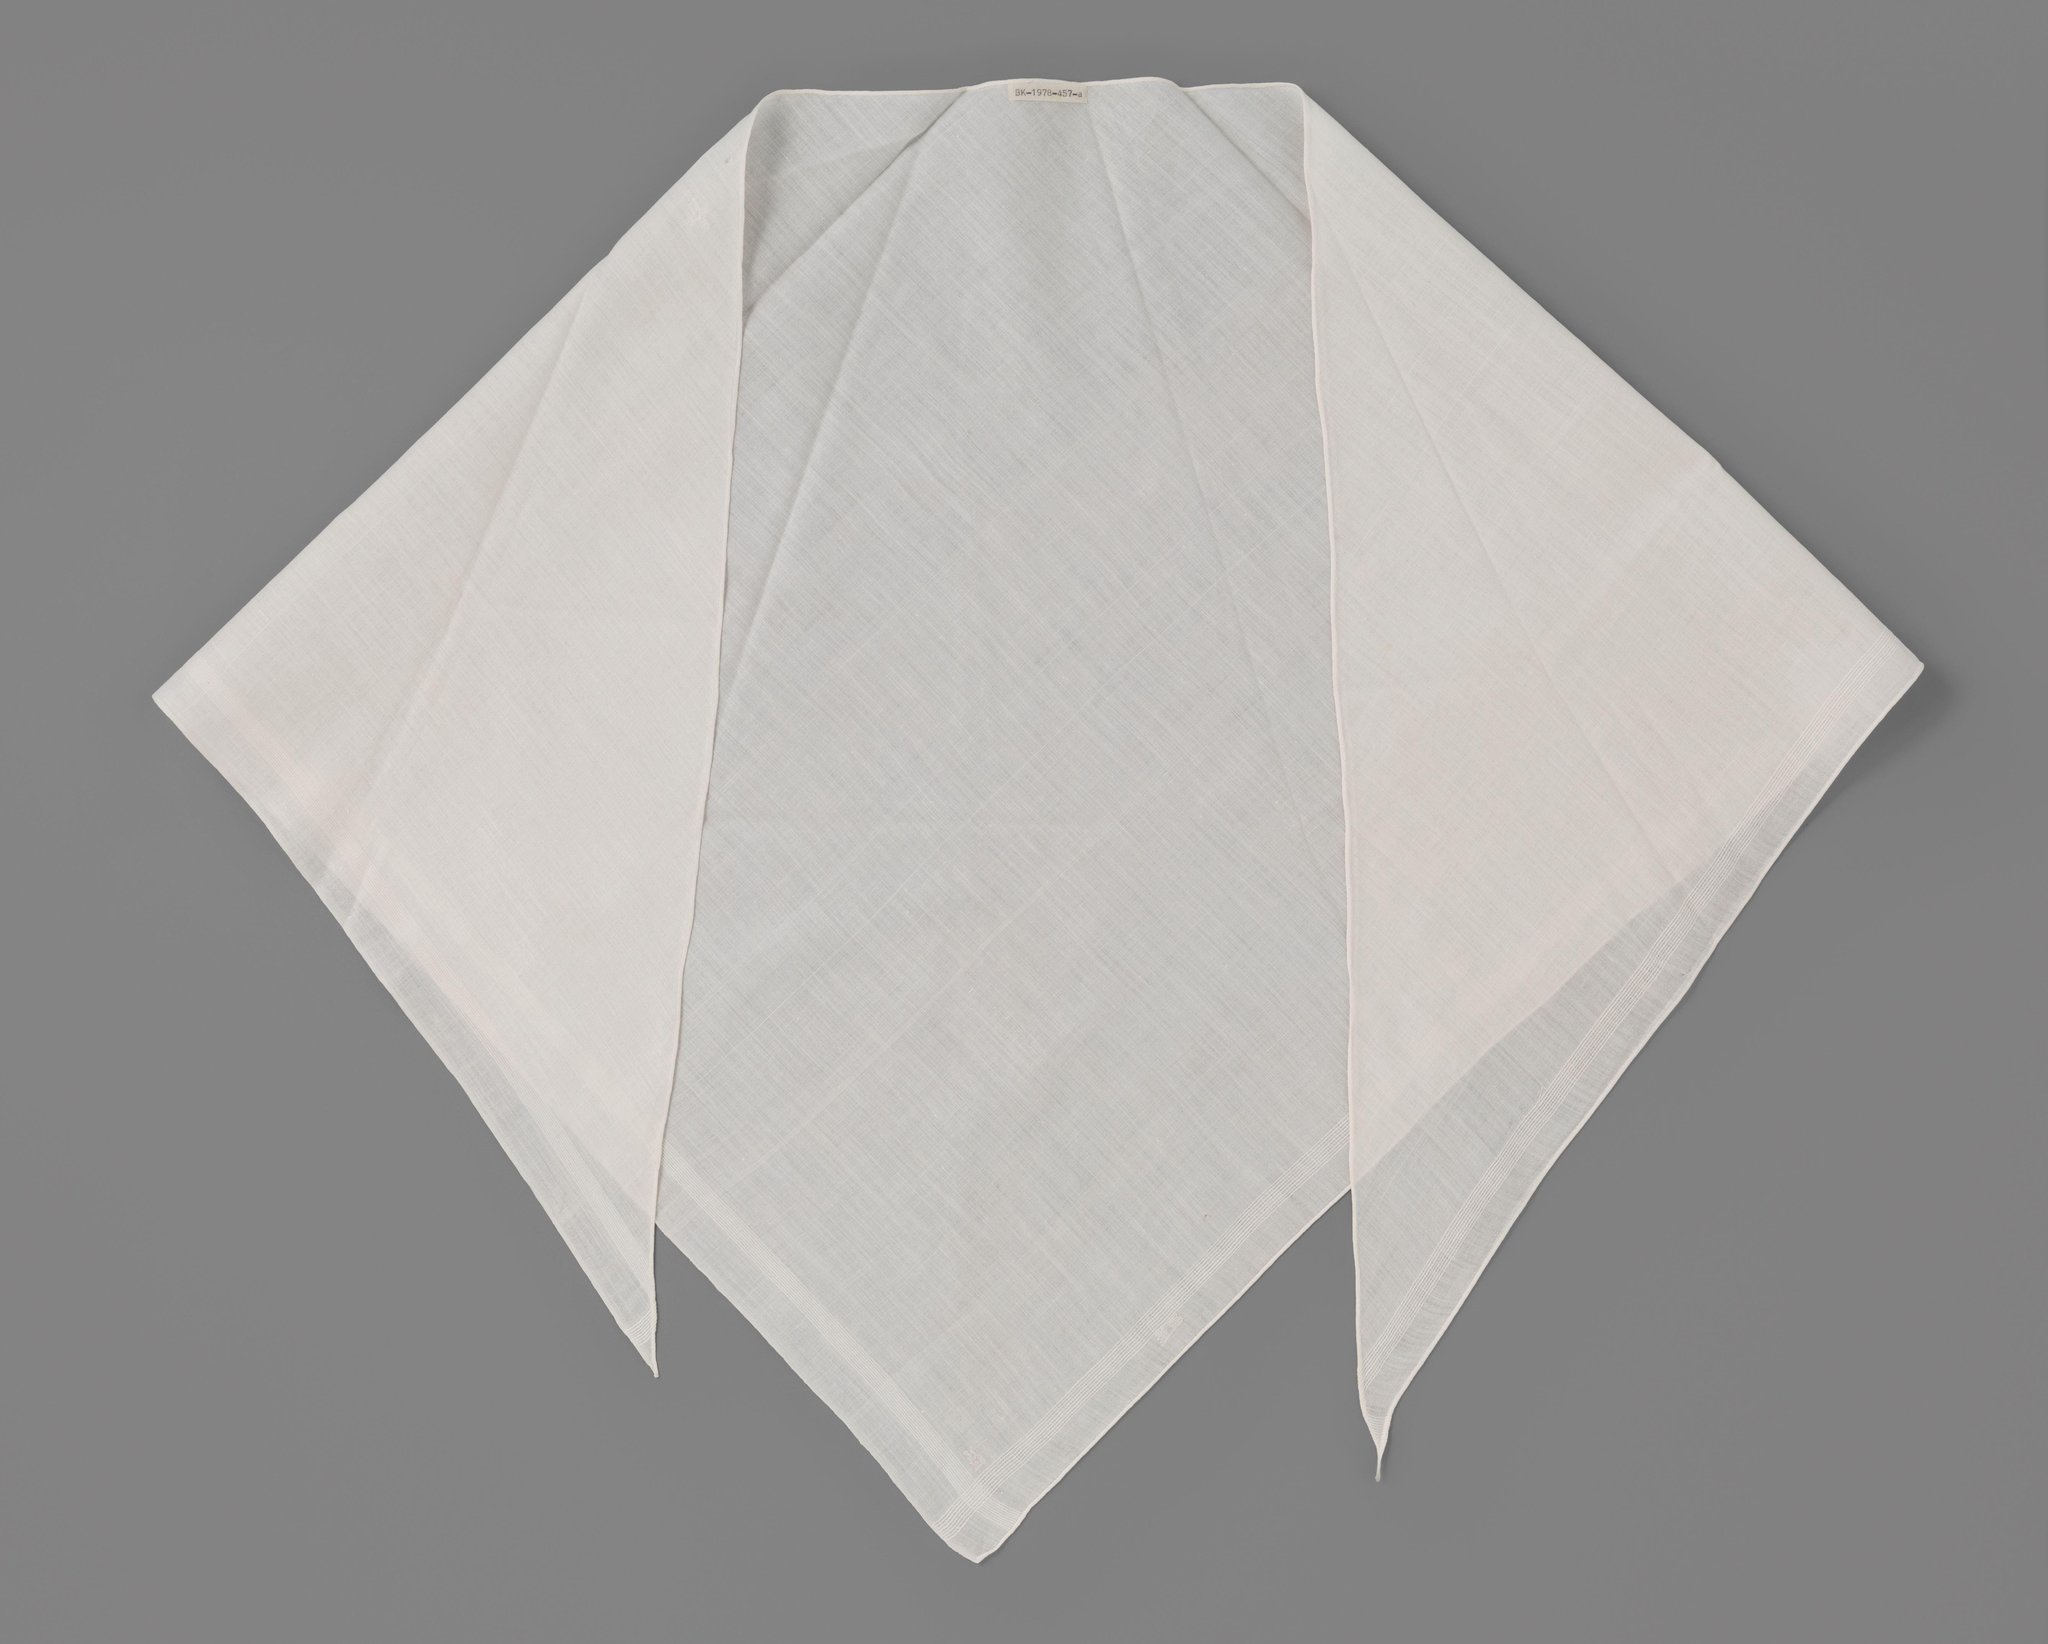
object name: fichu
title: Fichu van katoen, driehoekig, met rondom een rand van streepbiezen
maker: Anonymous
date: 1890-1900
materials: cotton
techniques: cross stitching, weave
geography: amsterdam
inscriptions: mark: ‘NS/ 24’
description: Fichu van katoen, driehoekig, met rondom een rand van streepbiezen. Model: een zijde zelfkant, overige twee platte zoom. Schuin op de draad gewerkt. In de punt met kleine rode kruissteken (gedeeltelijk vergaan) gemerkt "N S / 24" voor mevrouw H.M.A.F. (Nine) Six-Bosch Reitz.